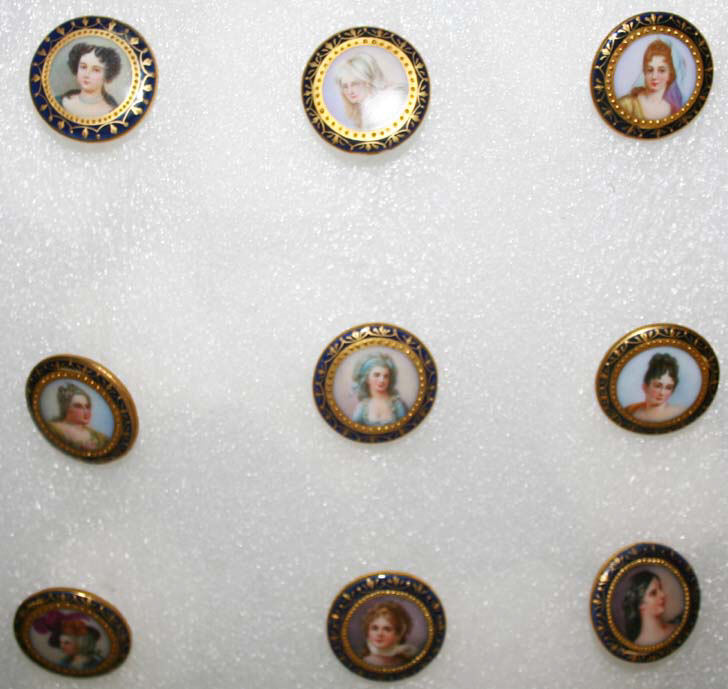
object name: button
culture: french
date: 1850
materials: metal, porcelain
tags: heads,portraits,women